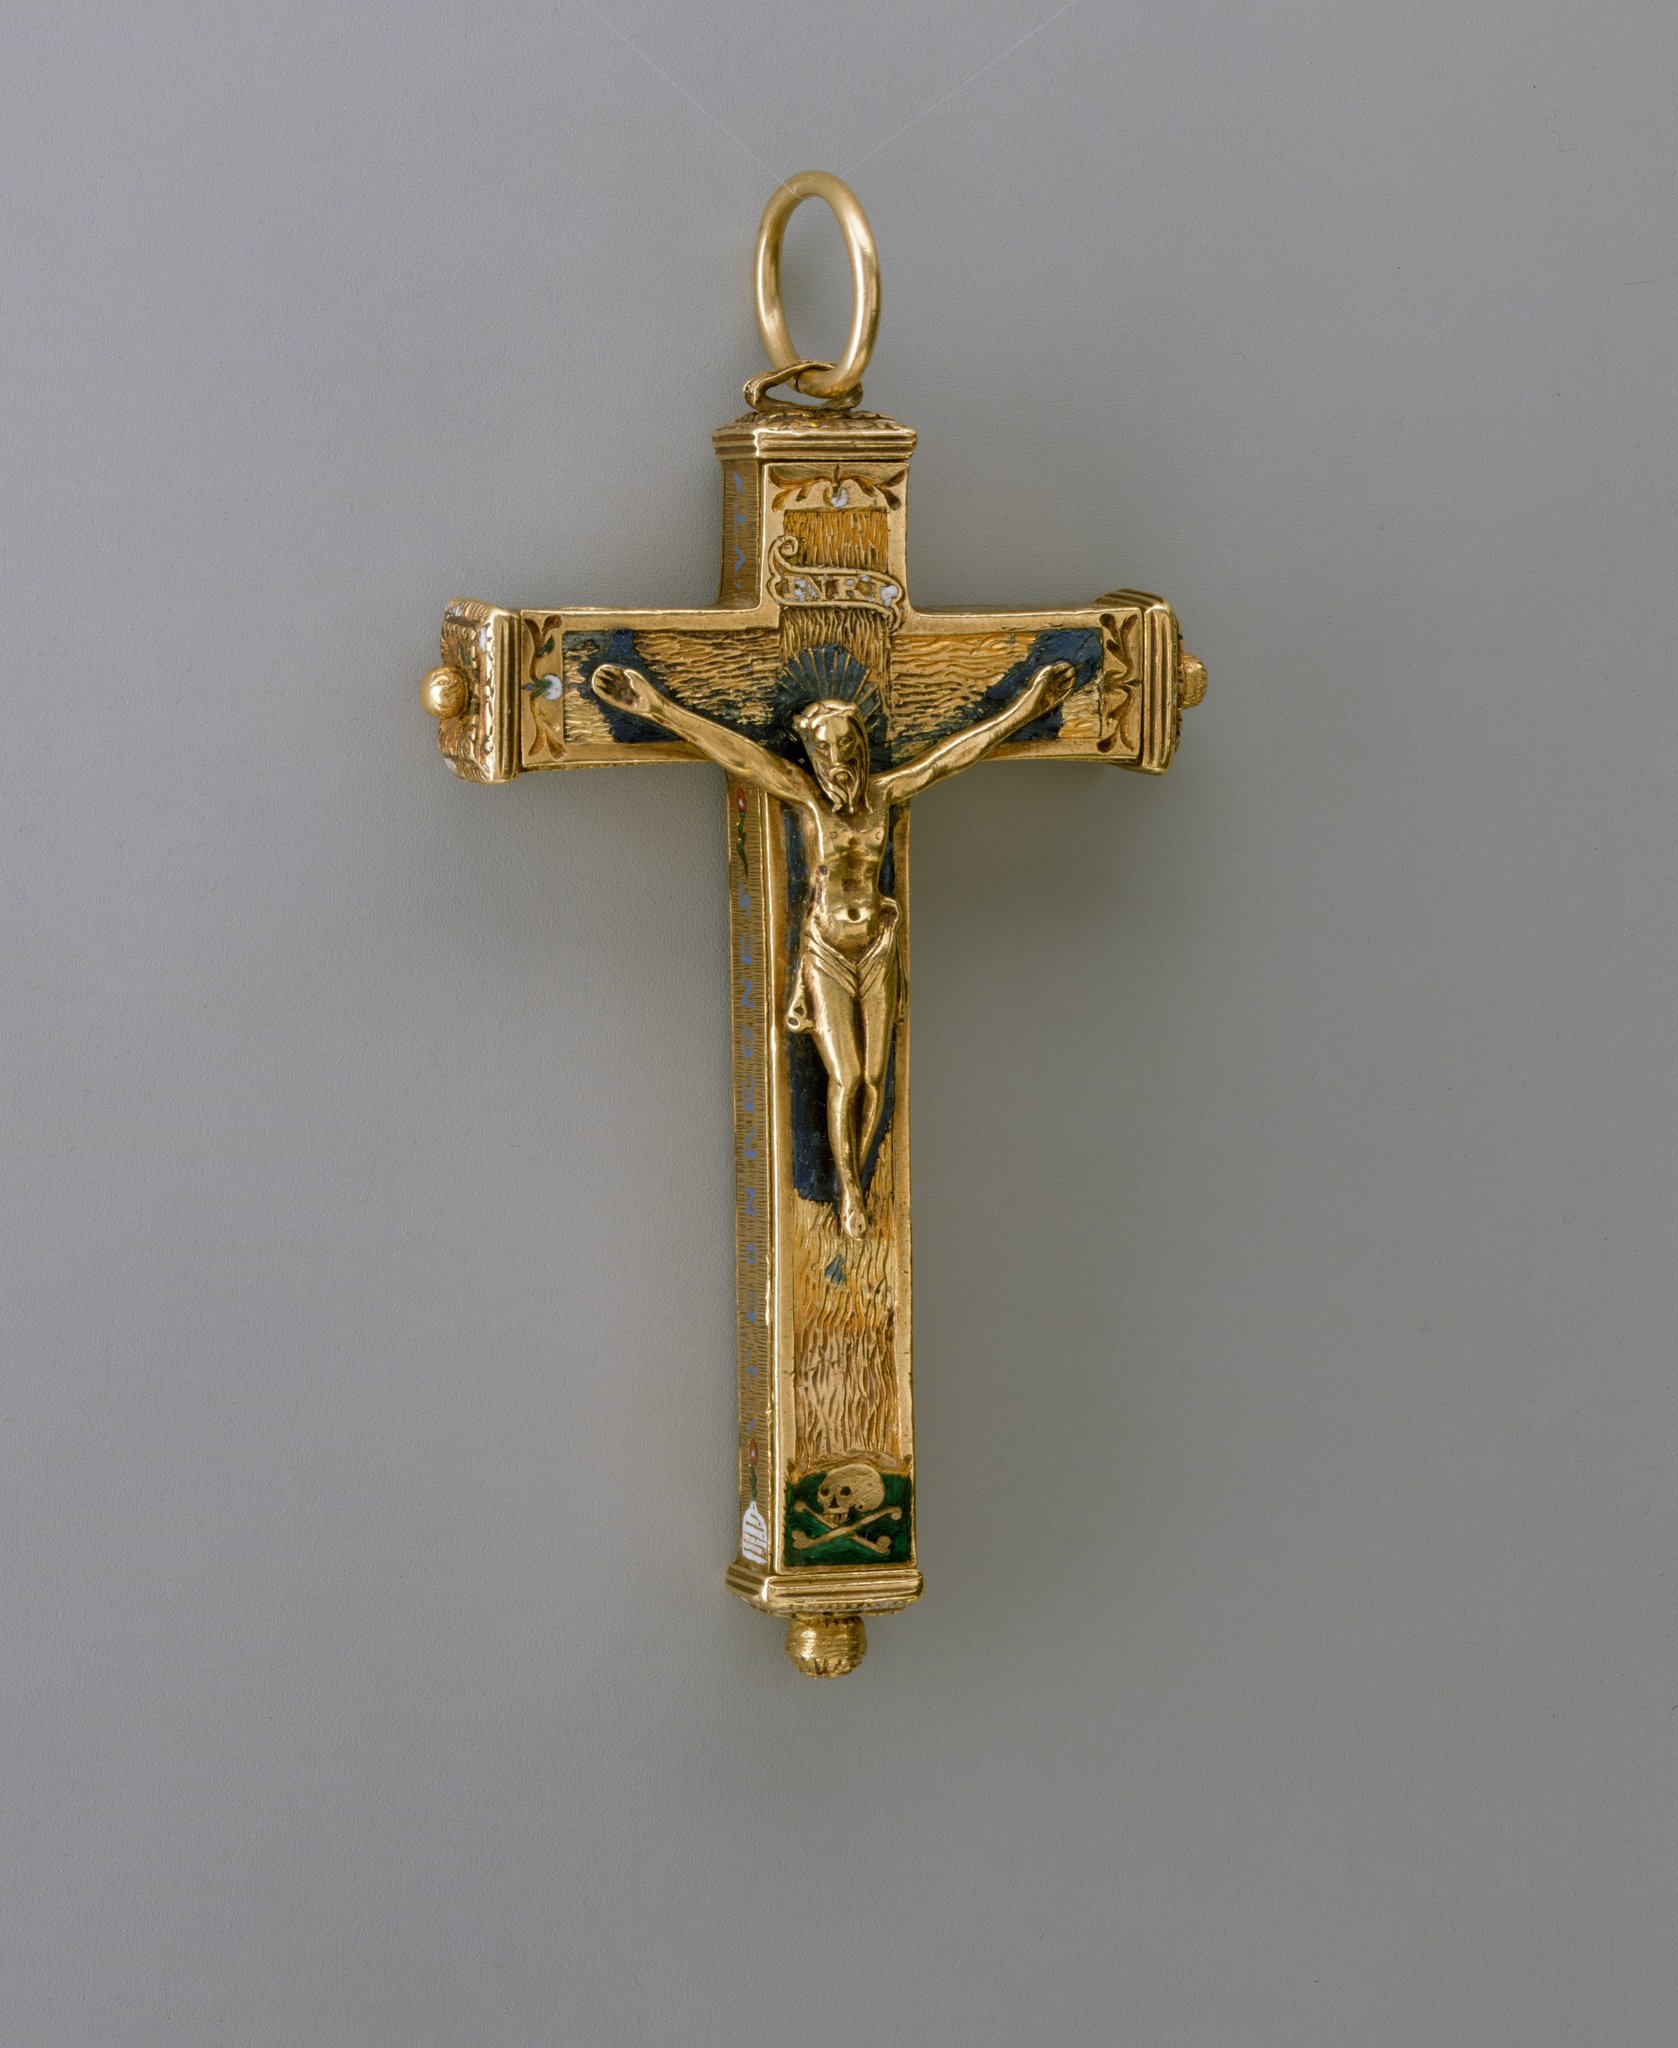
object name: pendant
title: Pendant in the Form of a Cross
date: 1567-1600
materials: gold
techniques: enamel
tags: christ,cross,crucifixion